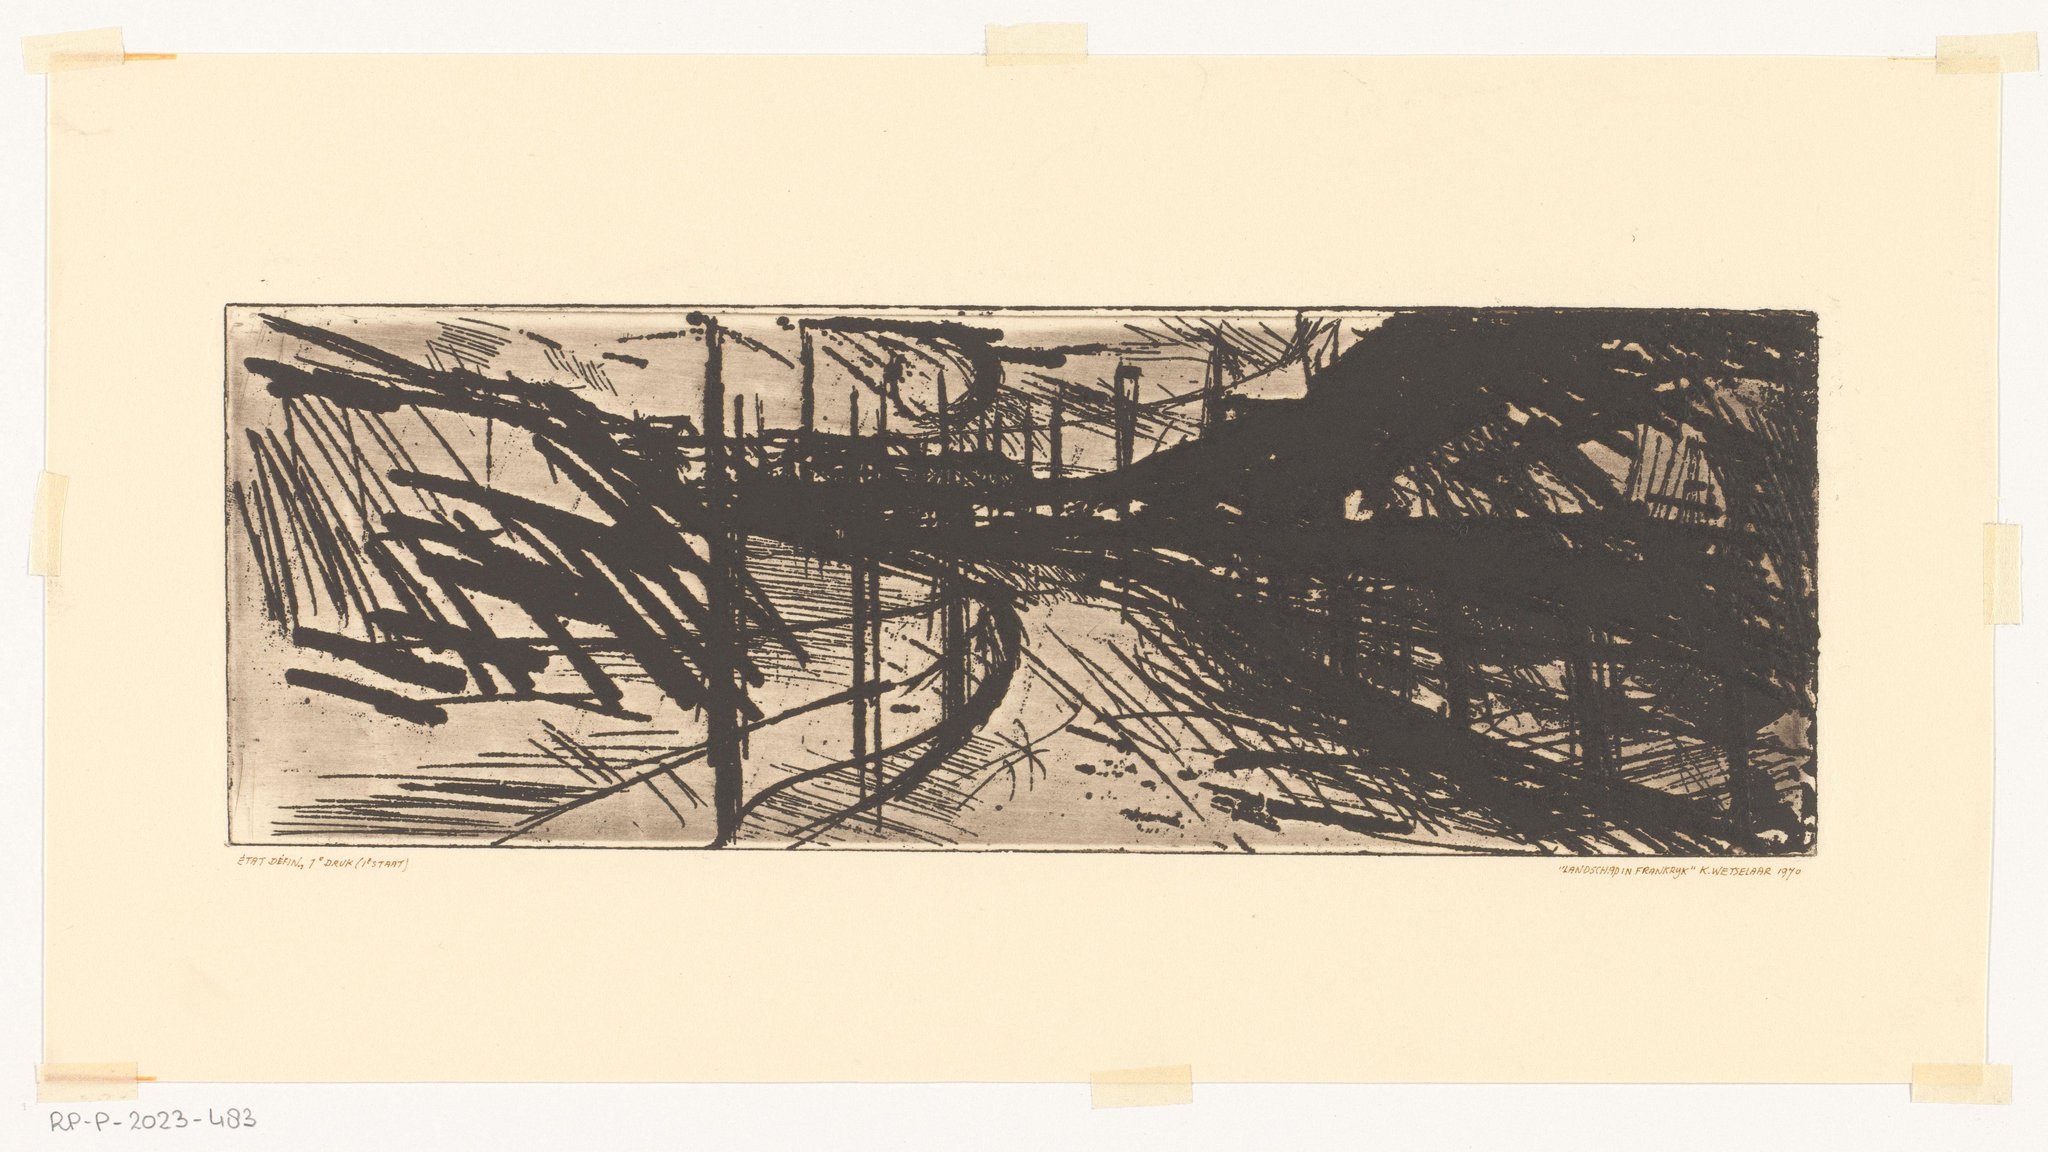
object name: print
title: Landschap in Frankrijk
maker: karel wetselaar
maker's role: print maker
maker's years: 1935-2017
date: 1970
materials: paper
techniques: etching, intaglio, linocut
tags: road, path, france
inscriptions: signature and date: ‘K. Wetselaar 1970’, inscription: ‘état défin., 1e druk (1e staat)’